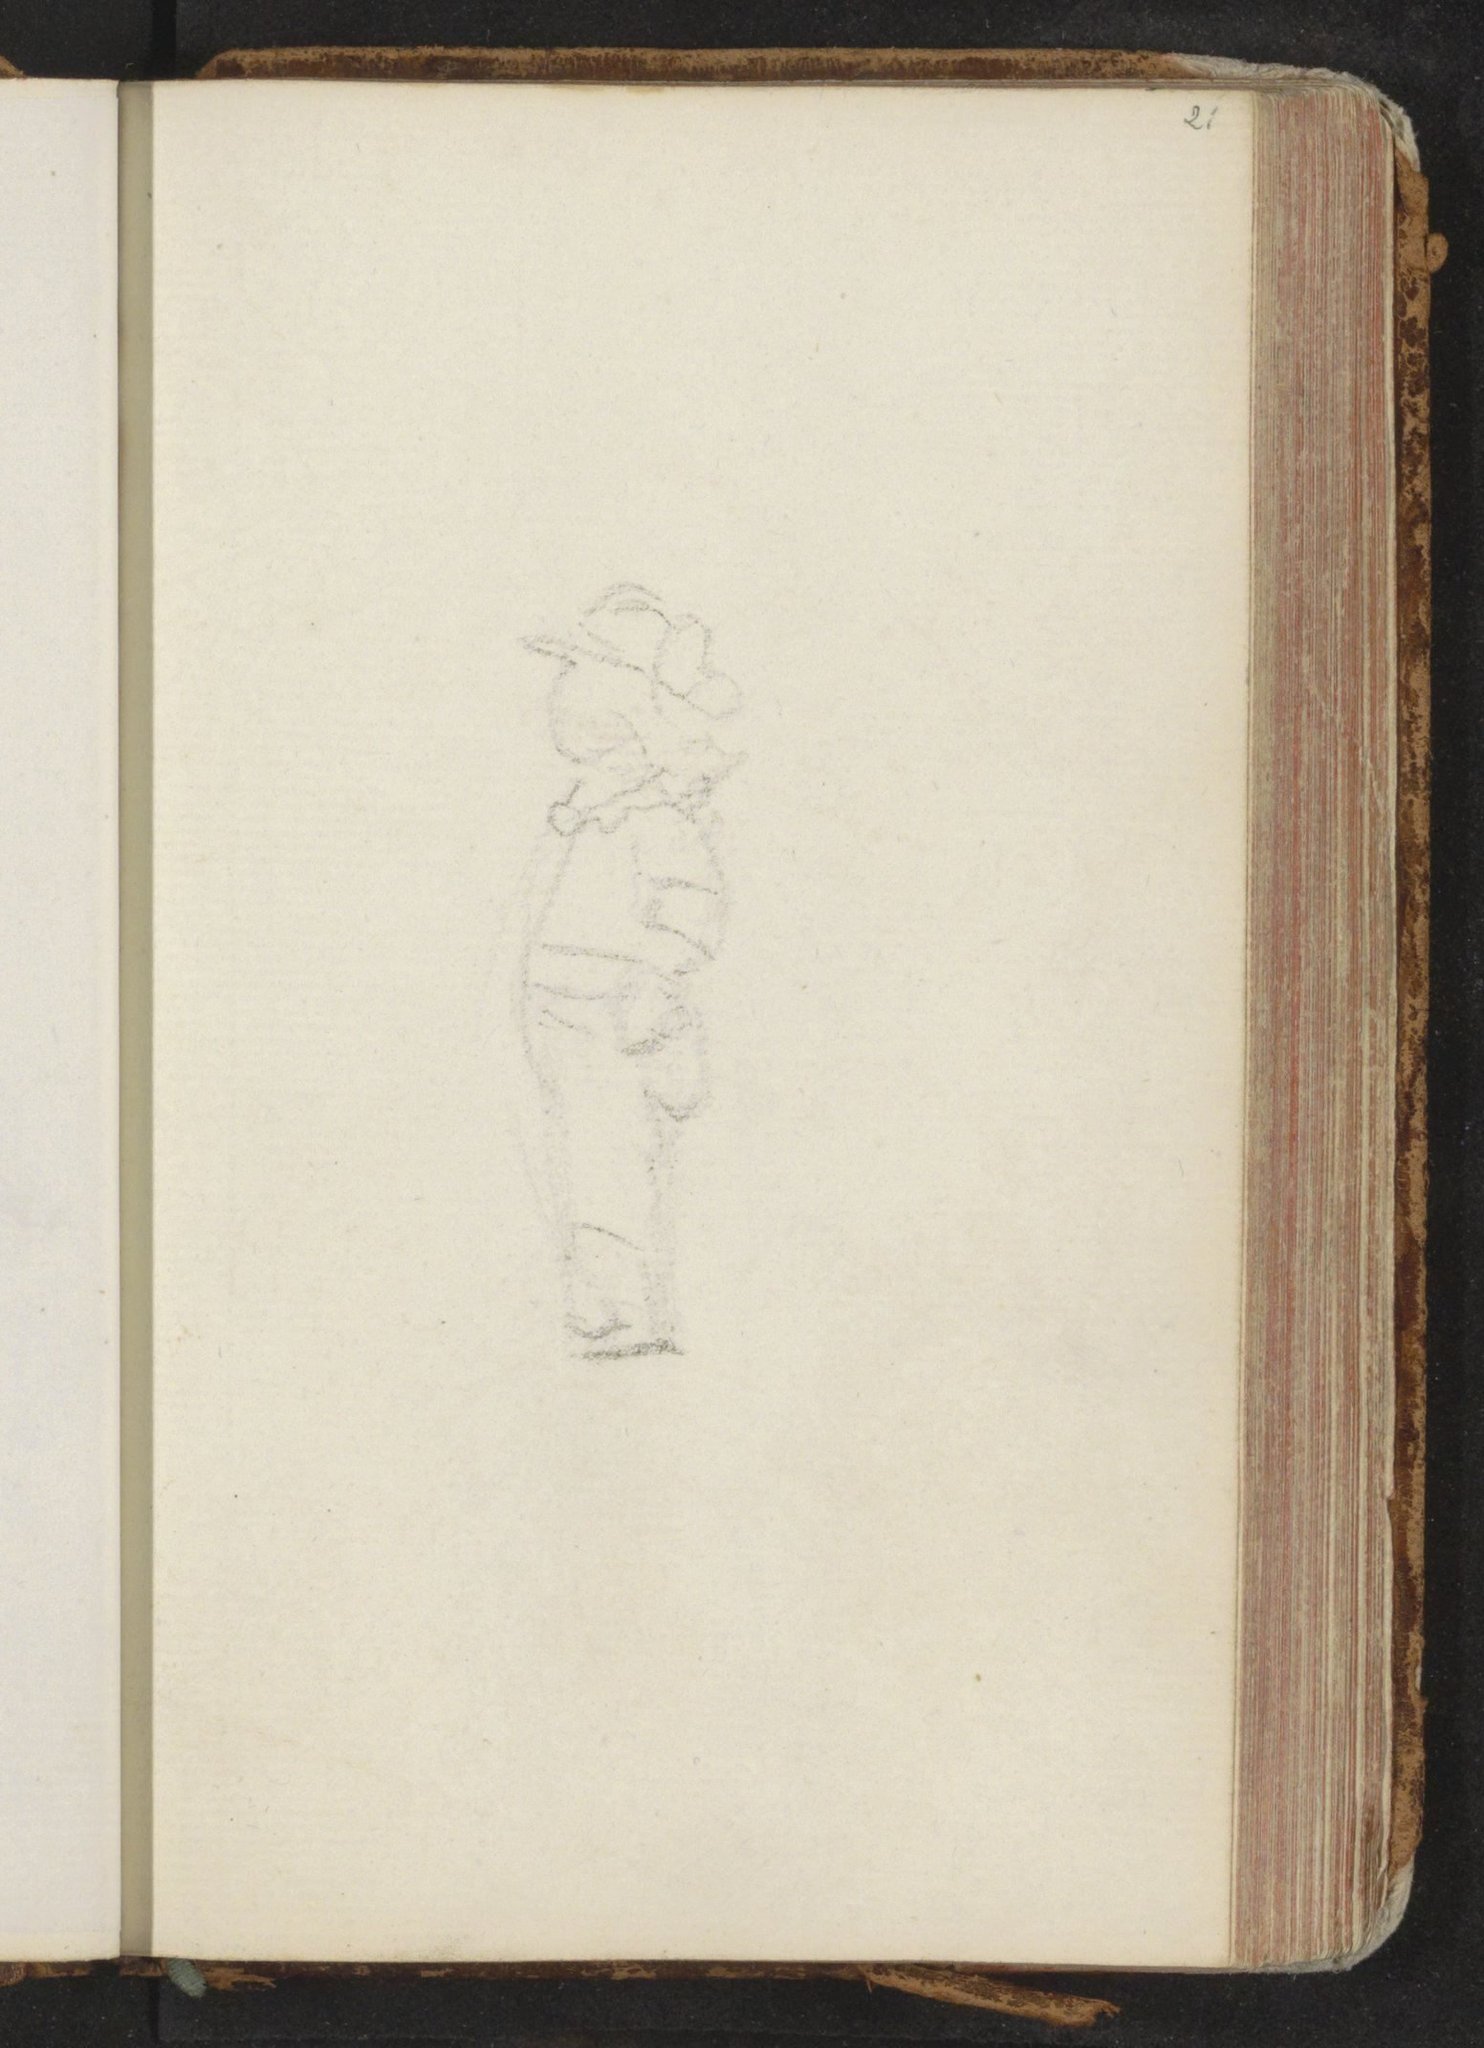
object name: sketchbook leaf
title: Staande figuur met een hoed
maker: jean honoré fragonard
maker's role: draughtsman, painter, print maker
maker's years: 1732-1806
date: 1765-1775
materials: paper, pencil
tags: standing figure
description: De figuur staat met de handen in de zakken. Blad 21 recto uit een schetsboek met 83 bladen.